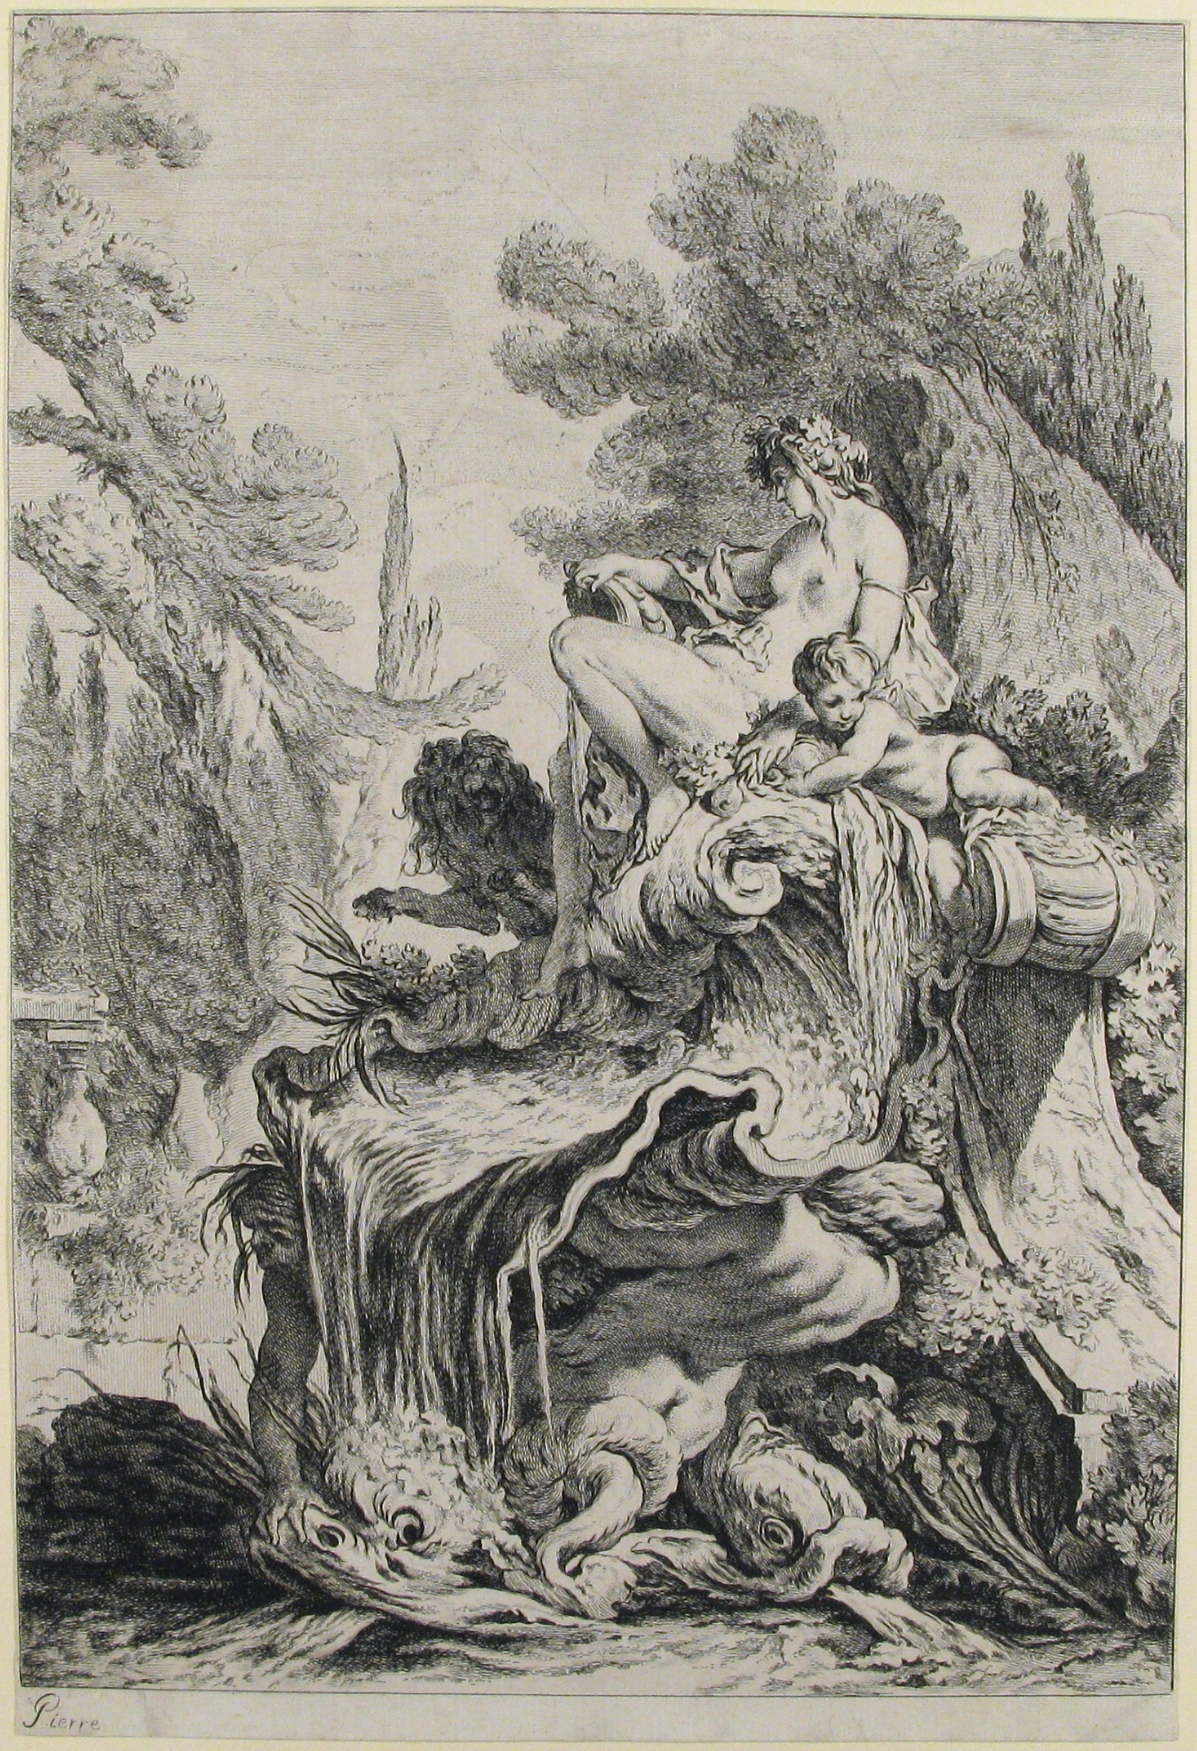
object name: print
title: Fountain with a Naiad Seated on a Shell (Une fontaine avec une näiade assise sur une conque)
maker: jean-baptiste marie pierre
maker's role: artist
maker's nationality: french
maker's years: 1714-1789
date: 1740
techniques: etching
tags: fountains,children,female nudes